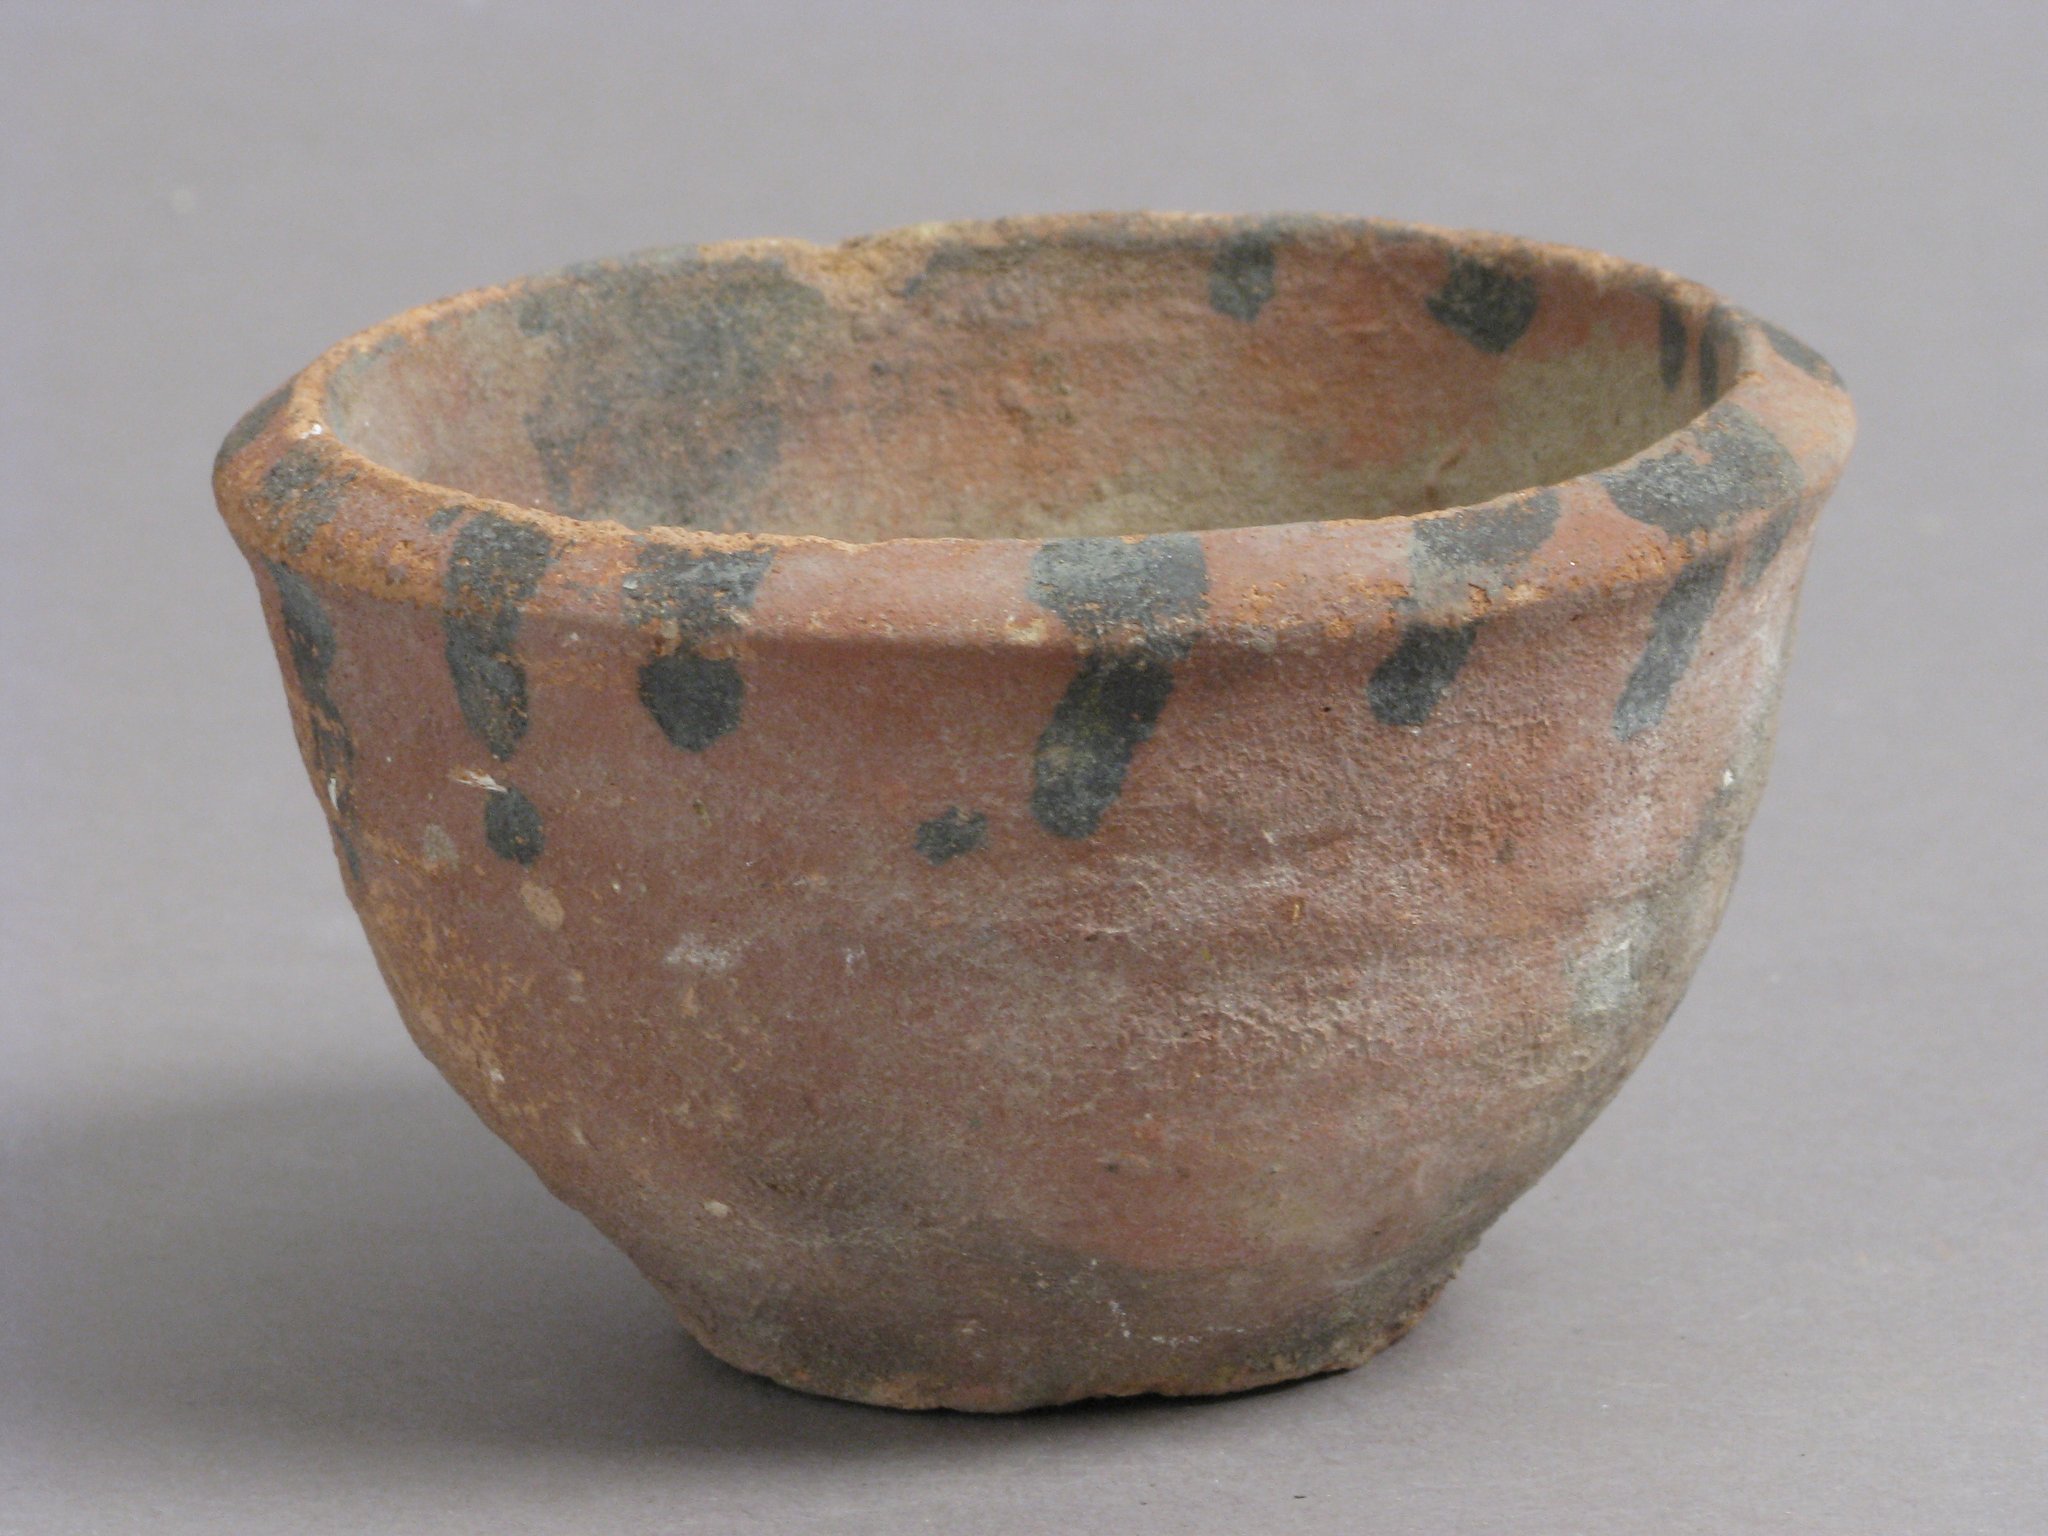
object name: bowl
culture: coptic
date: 301-700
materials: earthenware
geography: egypt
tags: bowls